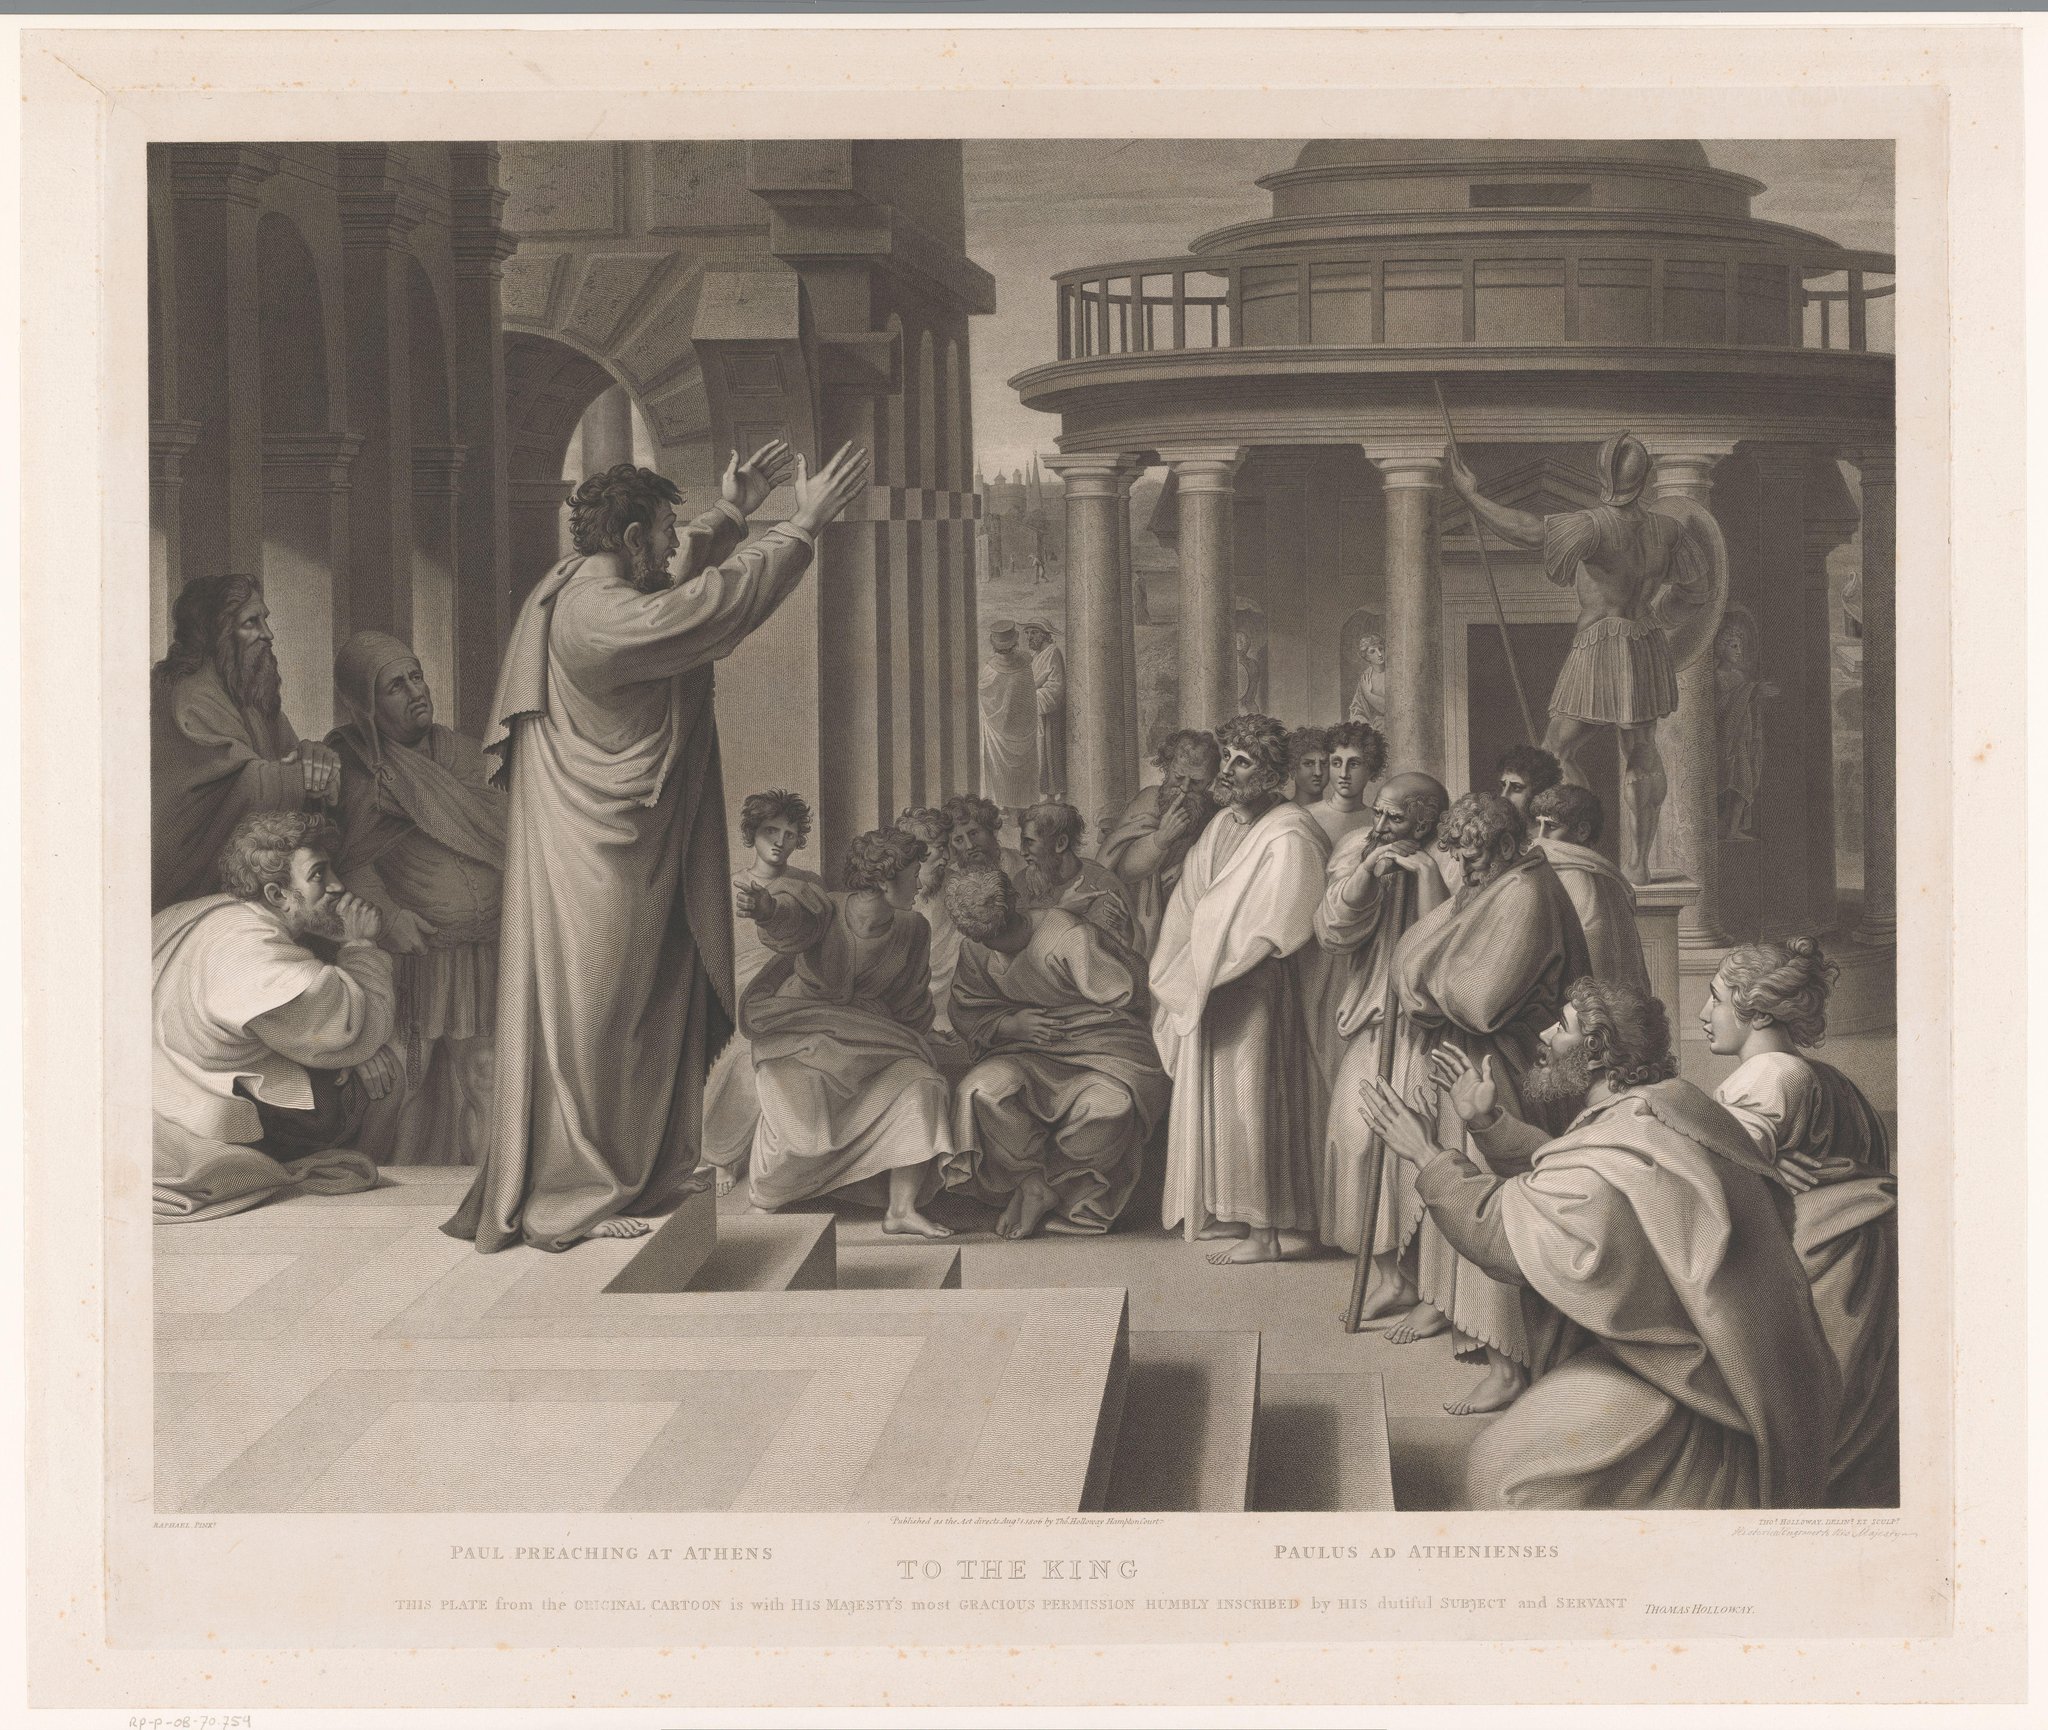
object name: print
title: Paulus predikt te Athene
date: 1806-1808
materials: paper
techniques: engraving, etching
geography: london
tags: paul in athens: on the areopagus he discusses with philosophers (in front of the temple of mars)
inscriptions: collector's mark: Lugt 12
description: Eerste prent uit een serie van zes prenten, later voortgezet in samenwerking met Robert Slann en T.S. Webb. De laatste prent van de serie werd in 1828 uitgegeven.